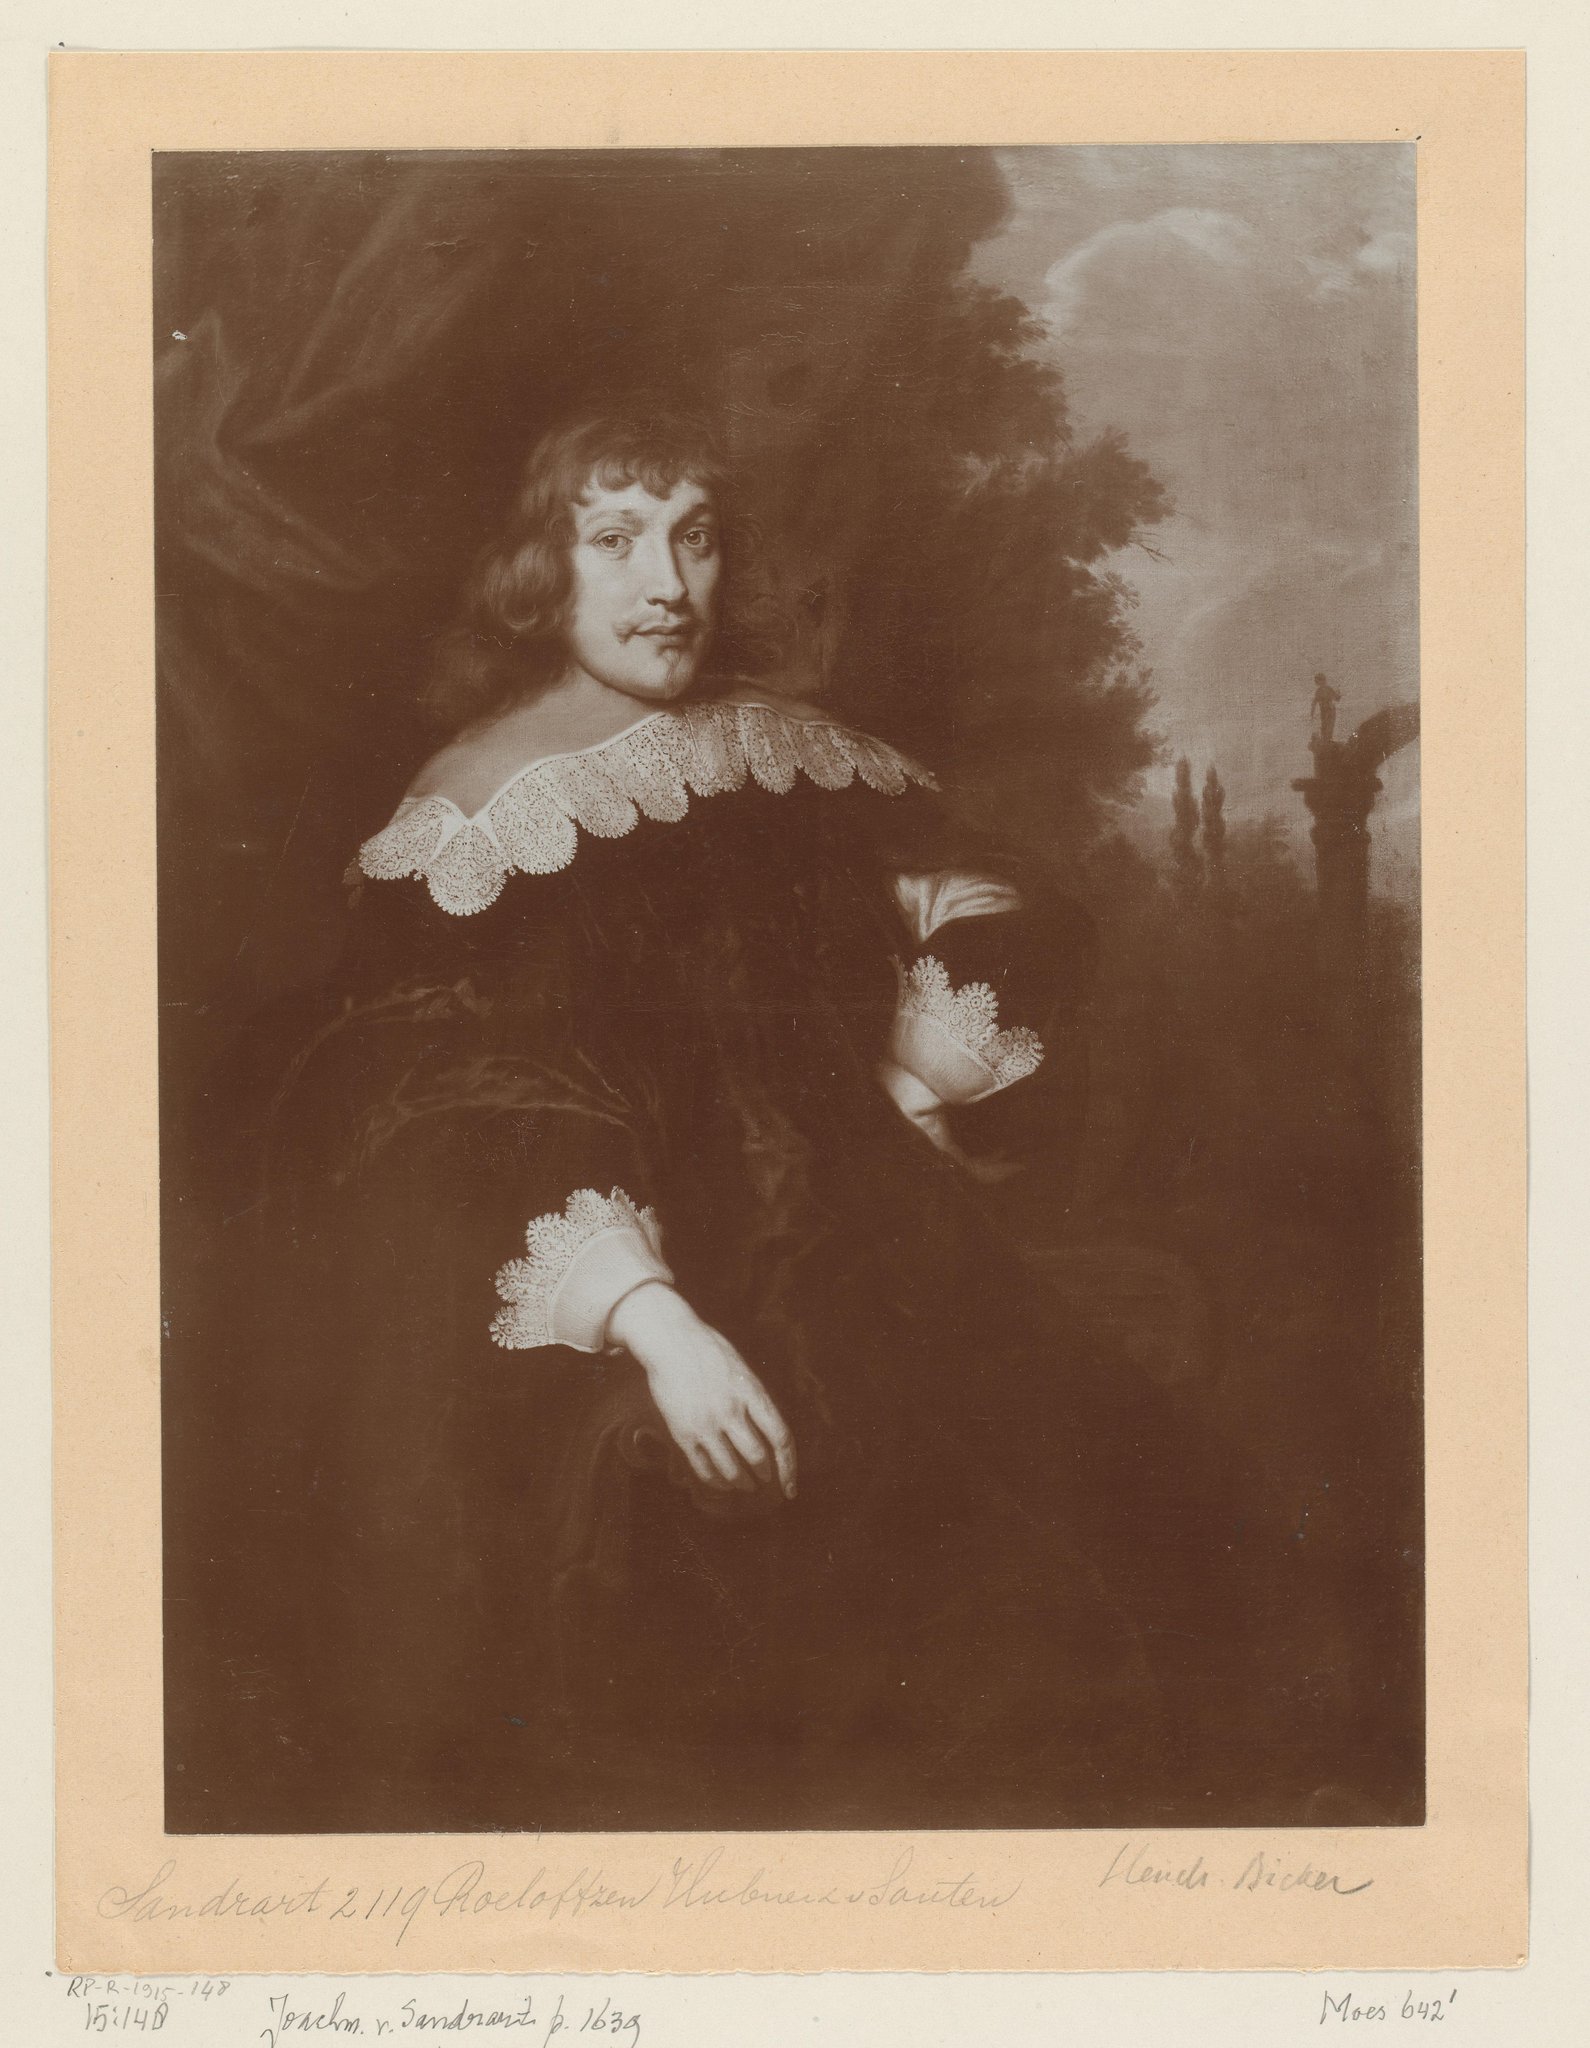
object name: photograph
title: Fotoreproductie van een geschilderd portret van Hendrick Bicker, door Joachim von Sandrart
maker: koop remmerts semplonius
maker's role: draughtsman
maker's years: 1847-1915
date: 1885-1915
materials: paper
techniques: collodion silver print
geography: amsterdam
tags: mayor, historical persons, officer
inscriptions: collector's mark: Lugt 2228